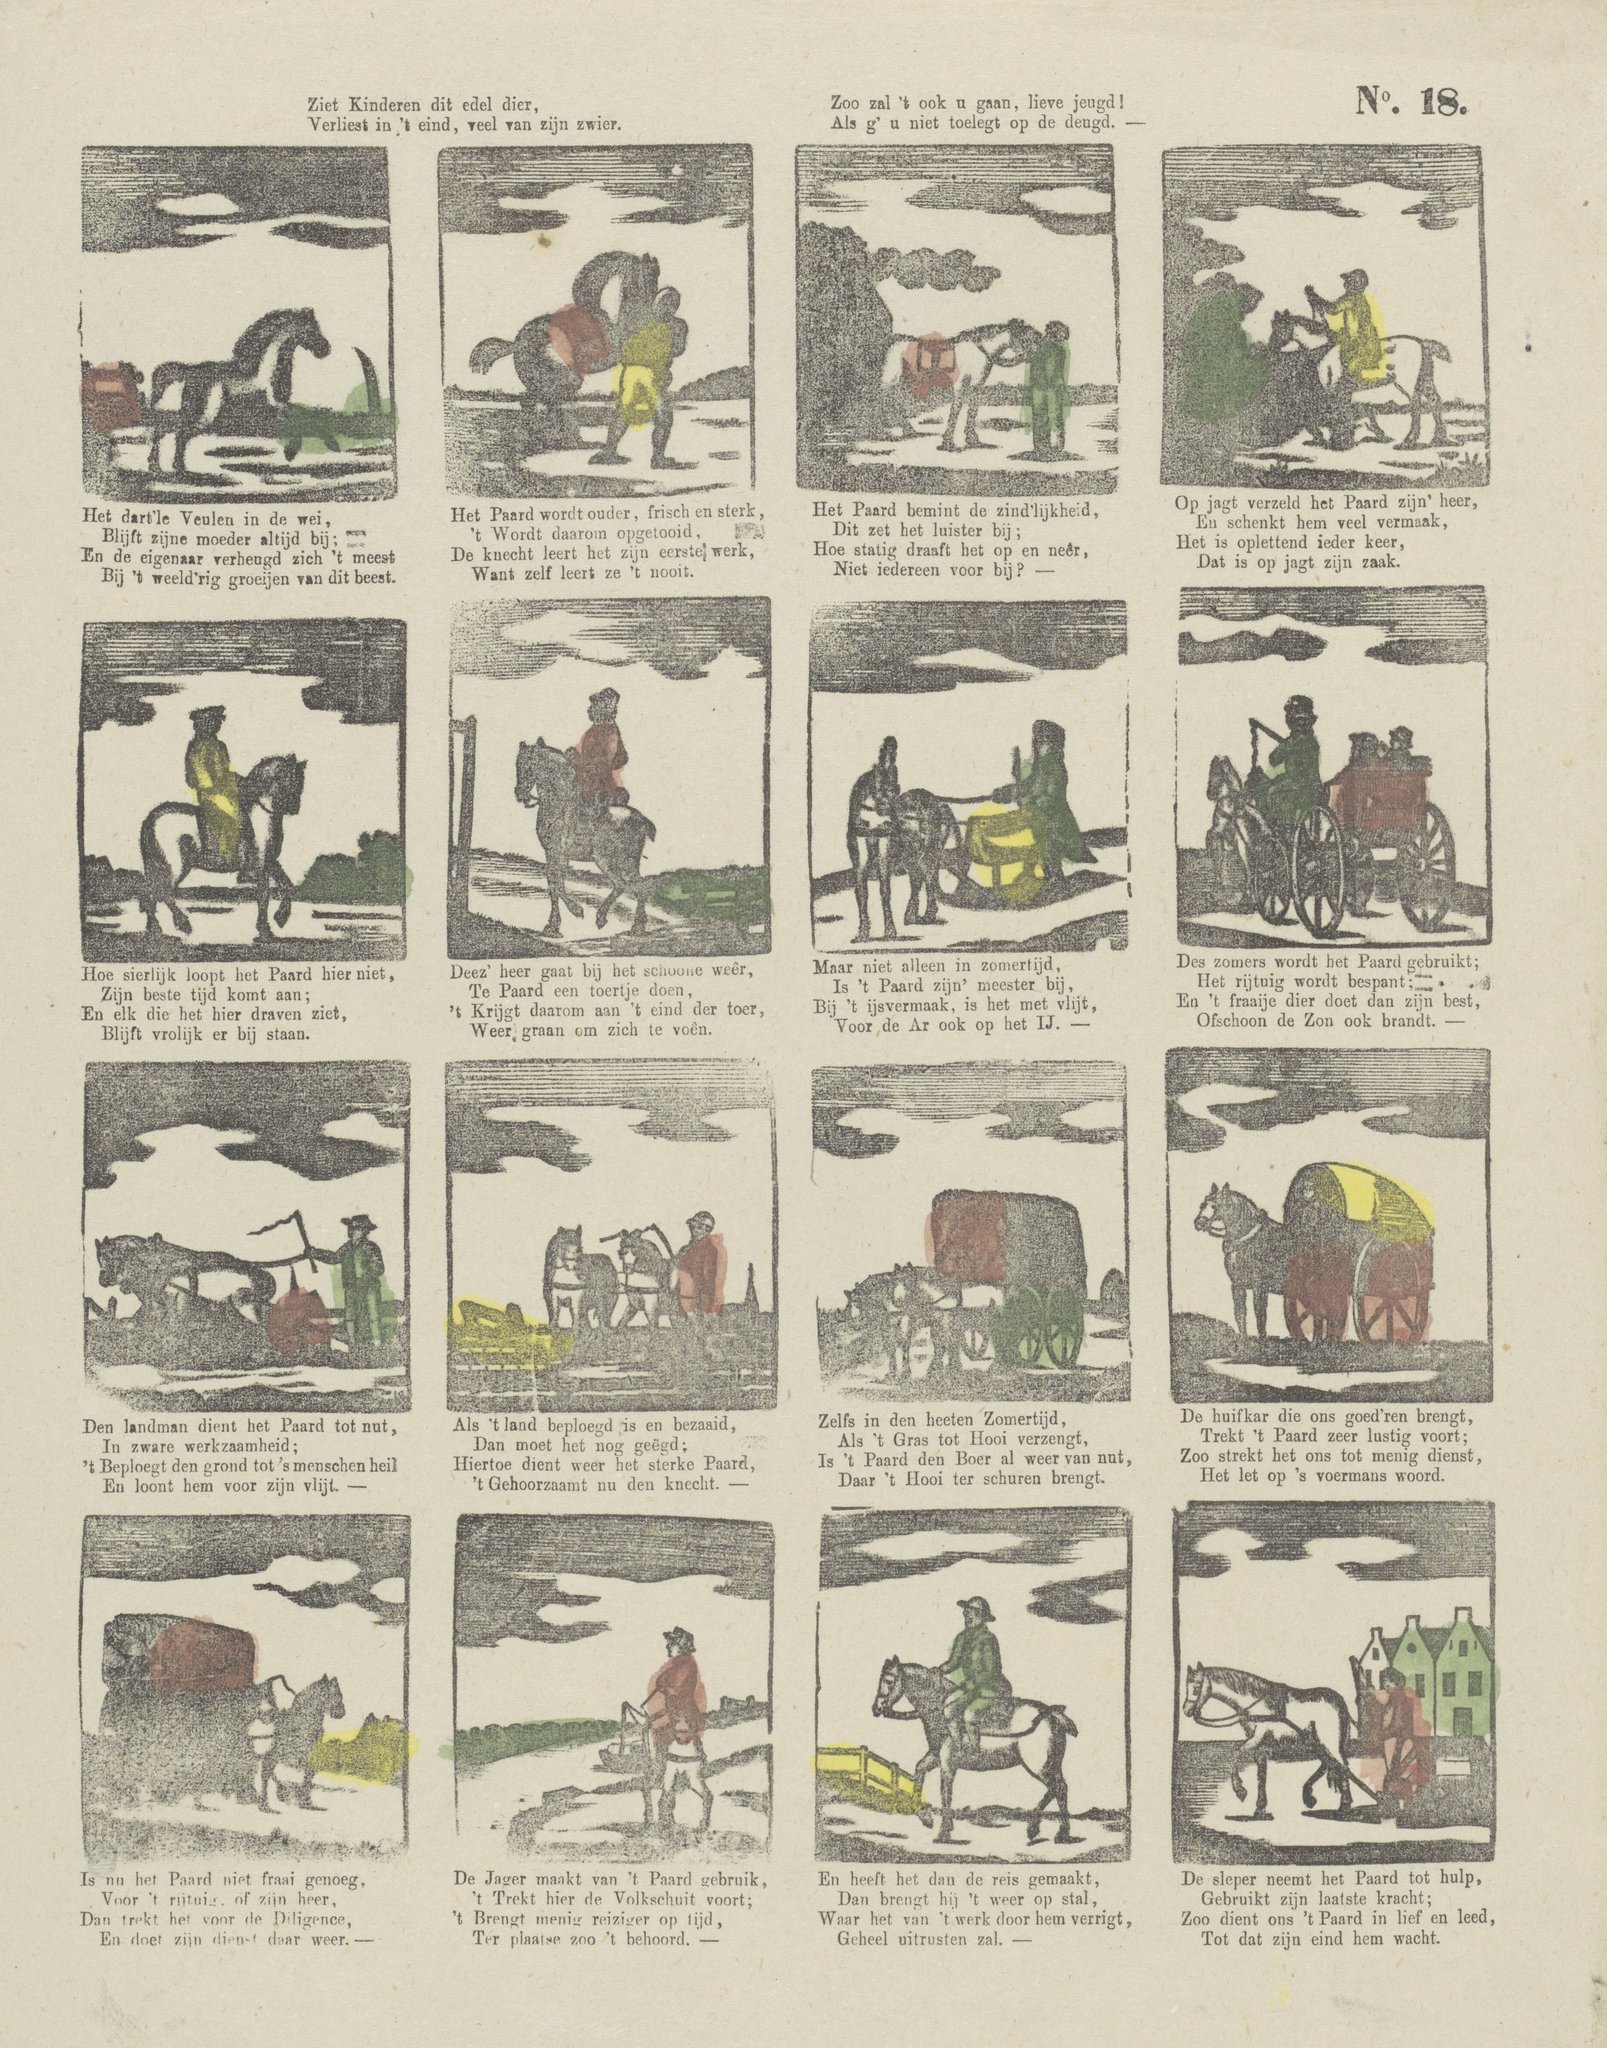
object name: popular print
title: Ziet kinderen! dit edele dier,/ Verliest in 't eind, veel van zijn zwier. / Zoo zal 't u gaan, o lieve jeugd! / Als ge u niet toelegt op de deugd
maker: willem bal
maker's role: print maker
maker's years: 1808-1897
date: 1850-1870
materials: paper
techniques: colour, letterpress printing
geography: netherlands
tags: four-wheeled, animal-drawn vehicle, e.g.: cab, carriage, coach, horse, two-wheeled vehicle drawn by one animal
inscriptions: collector's mark: Lugt 2760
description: Blad met 16 voorstellingen van de verschillende bezigheden van een paard. Onder elke voorstelling een vierregelig vers. Rechtsboven genummerd: No. 18.